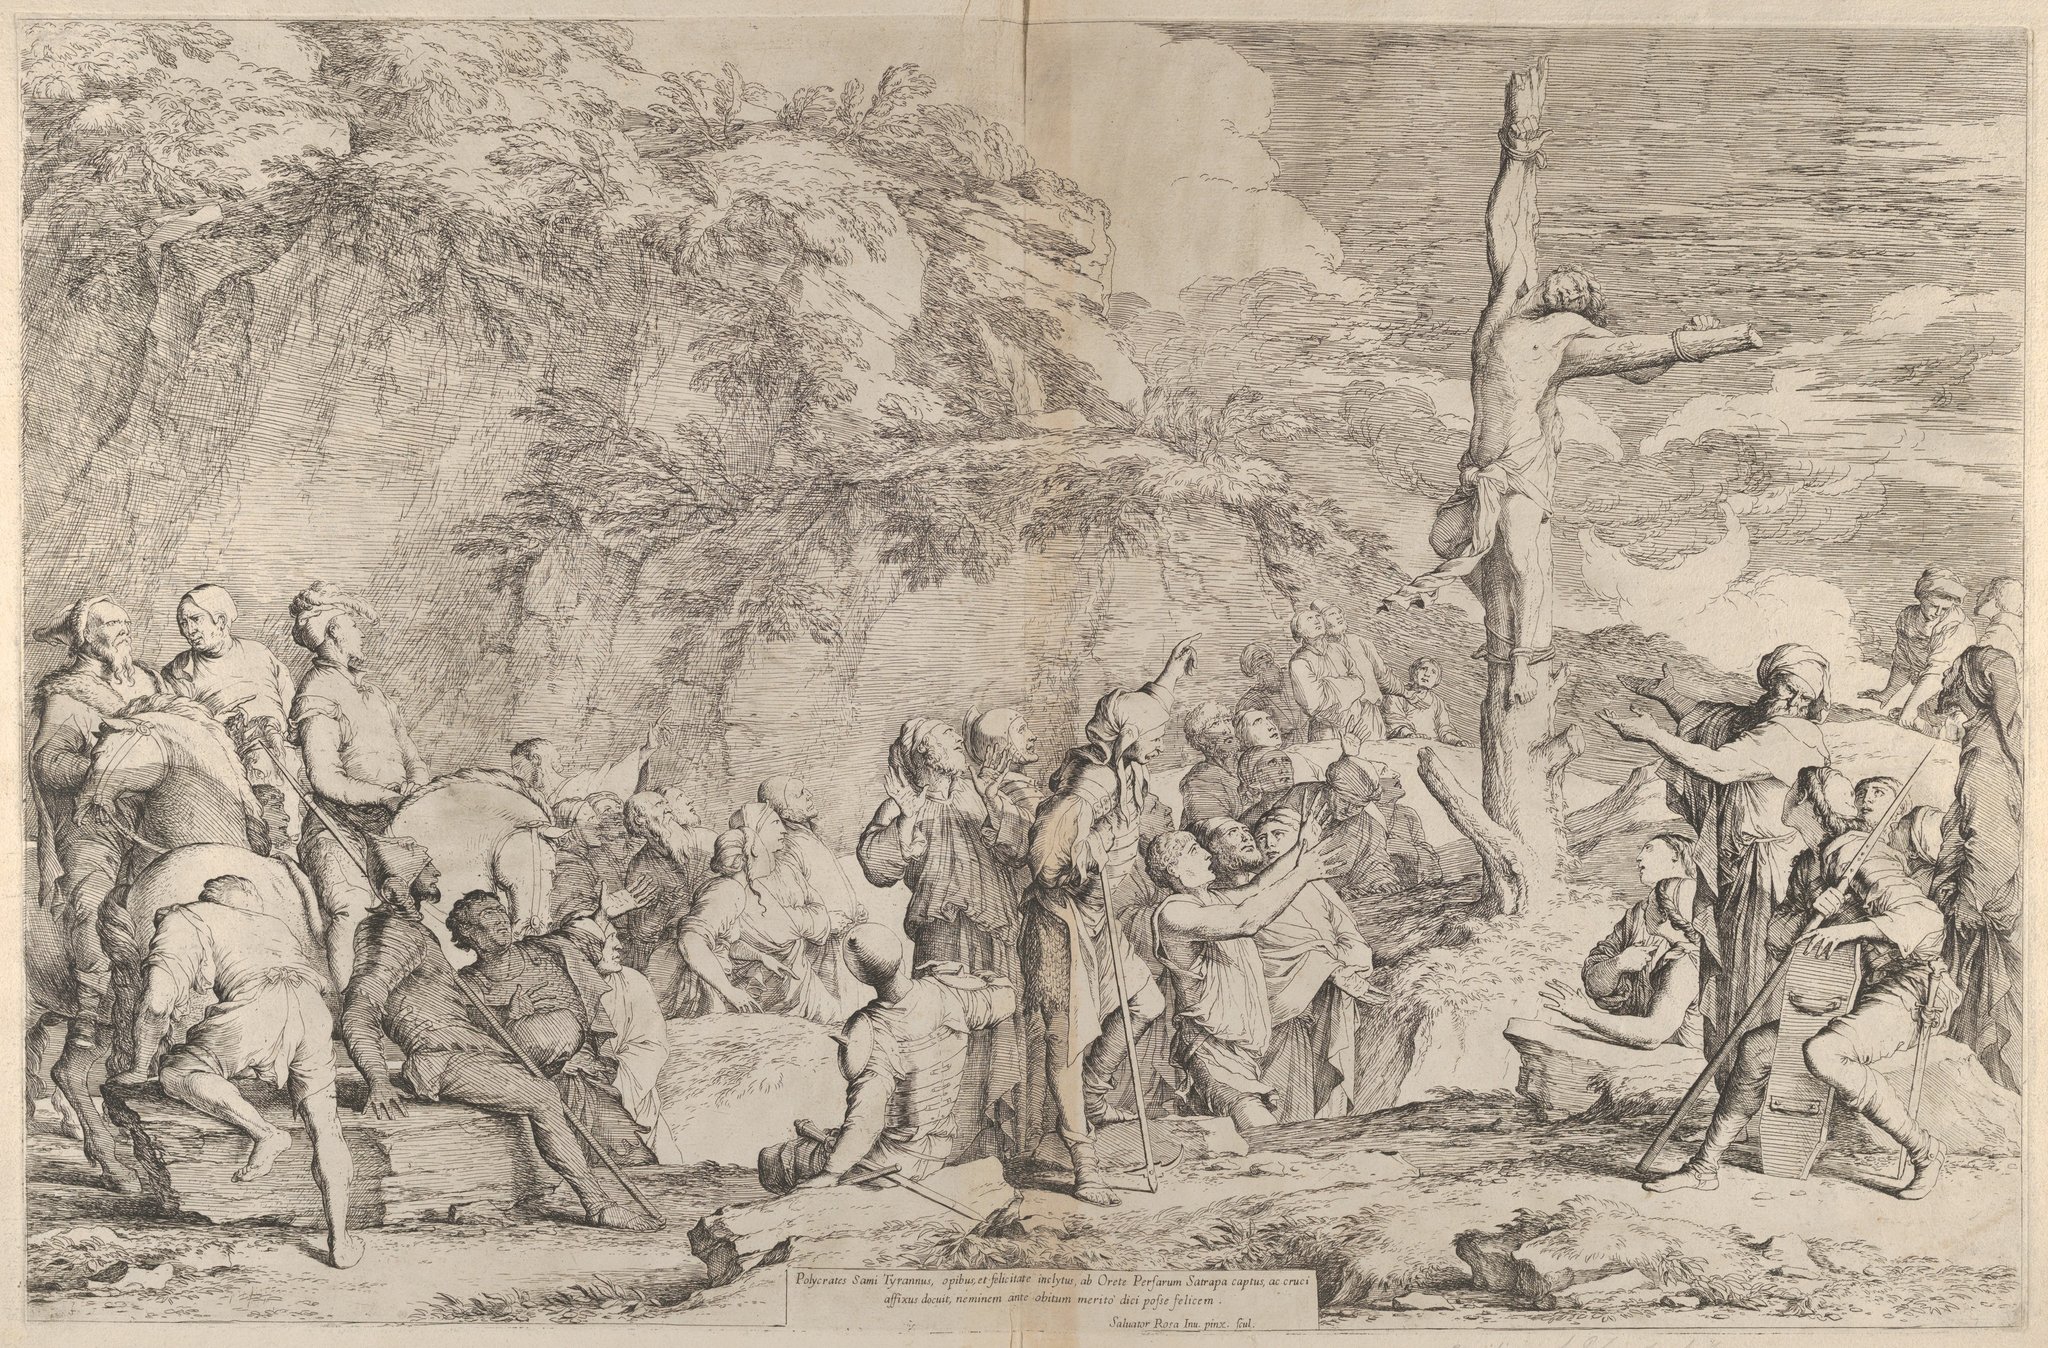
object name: print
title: The crucifixion of Polycrates the tyrant after his capture by the Persians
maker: salvator rosa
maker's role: artist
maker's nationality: italian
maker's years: 1615-1673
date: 1662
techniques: etching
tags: men,women,crucifixion